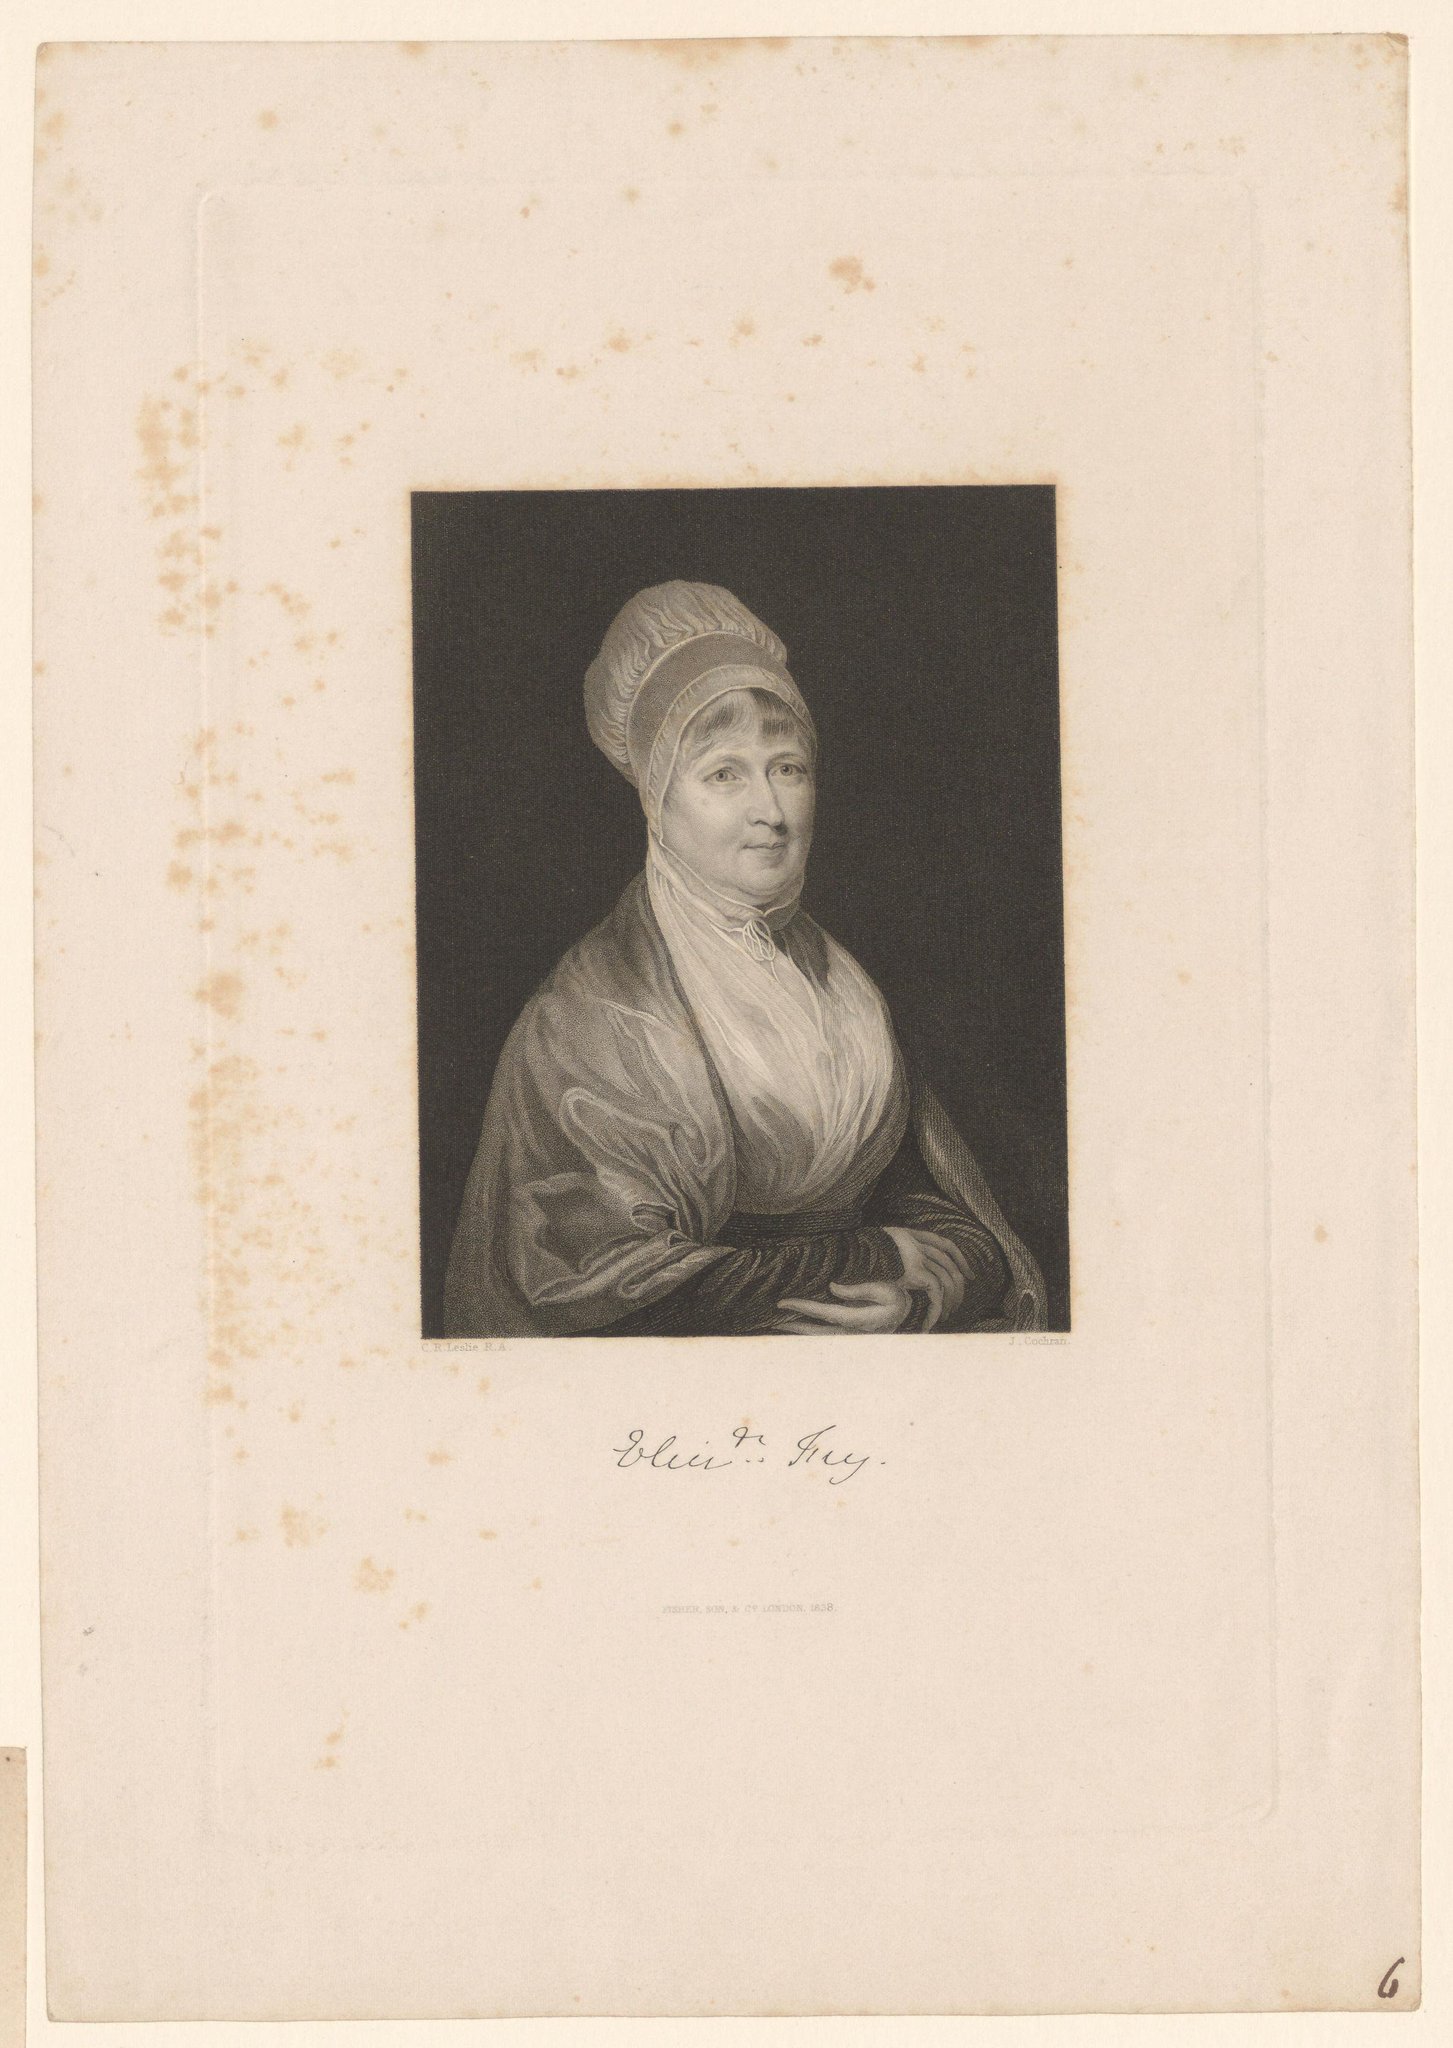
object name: print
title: Portret van Elizabeth Frey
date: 1838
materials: paper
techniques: etching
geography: london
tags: historical persons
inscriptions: collector's mark: Lugt 2228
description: Een facsimile signatuur in de ondermarge.